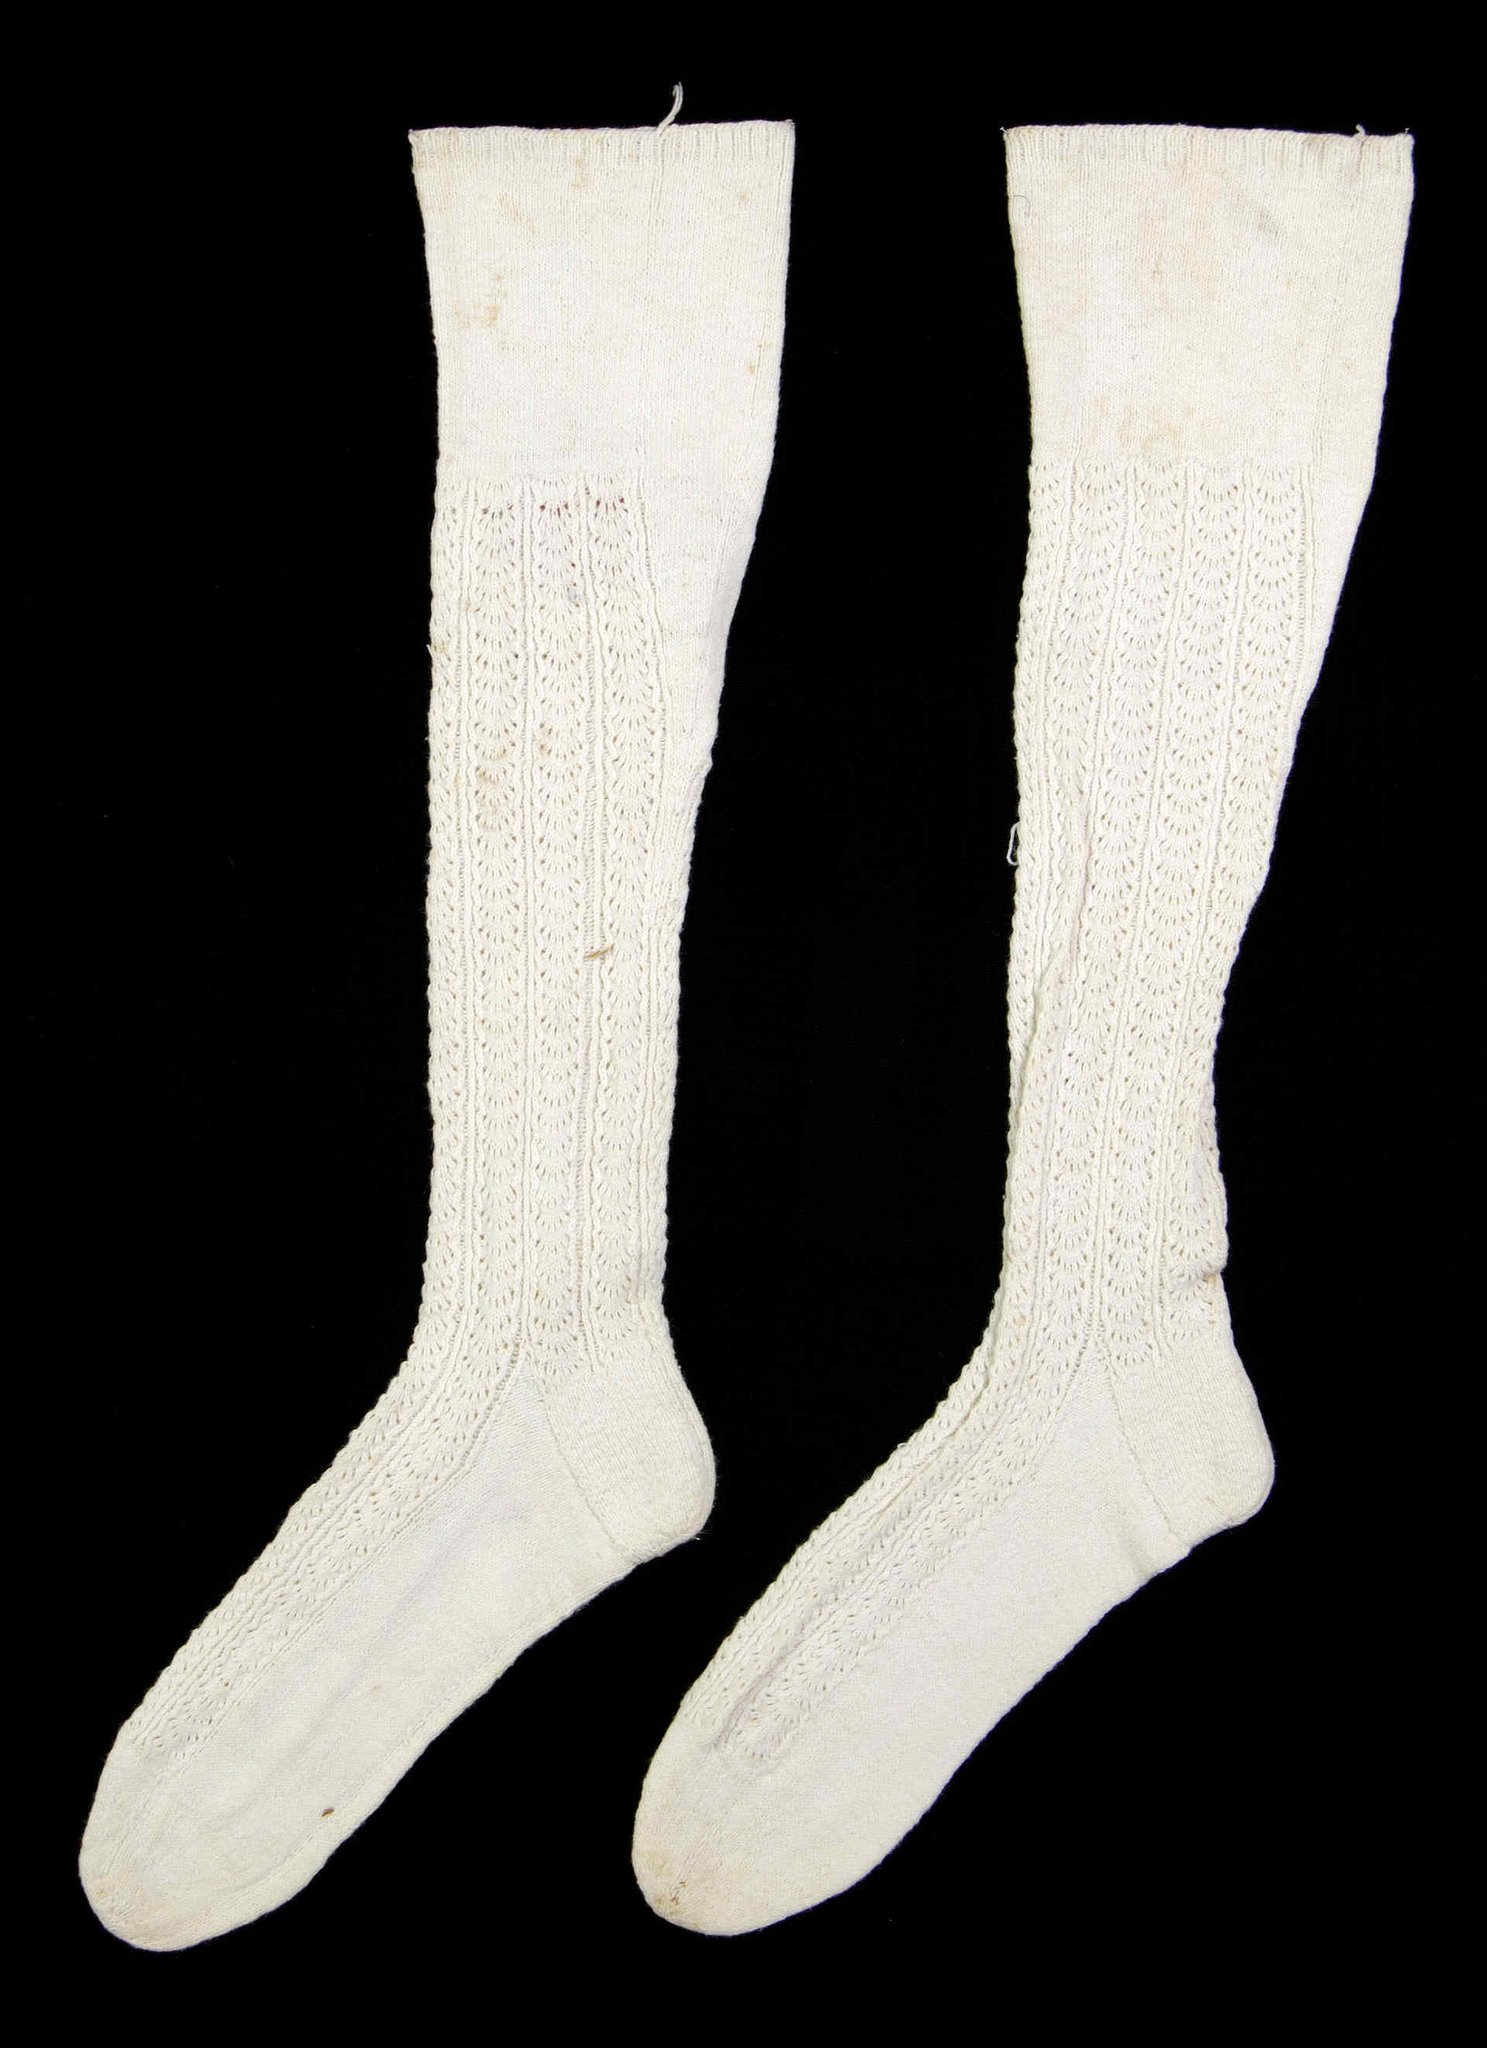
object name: stocking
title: Stockings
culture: american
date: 1825-1840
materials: cotton